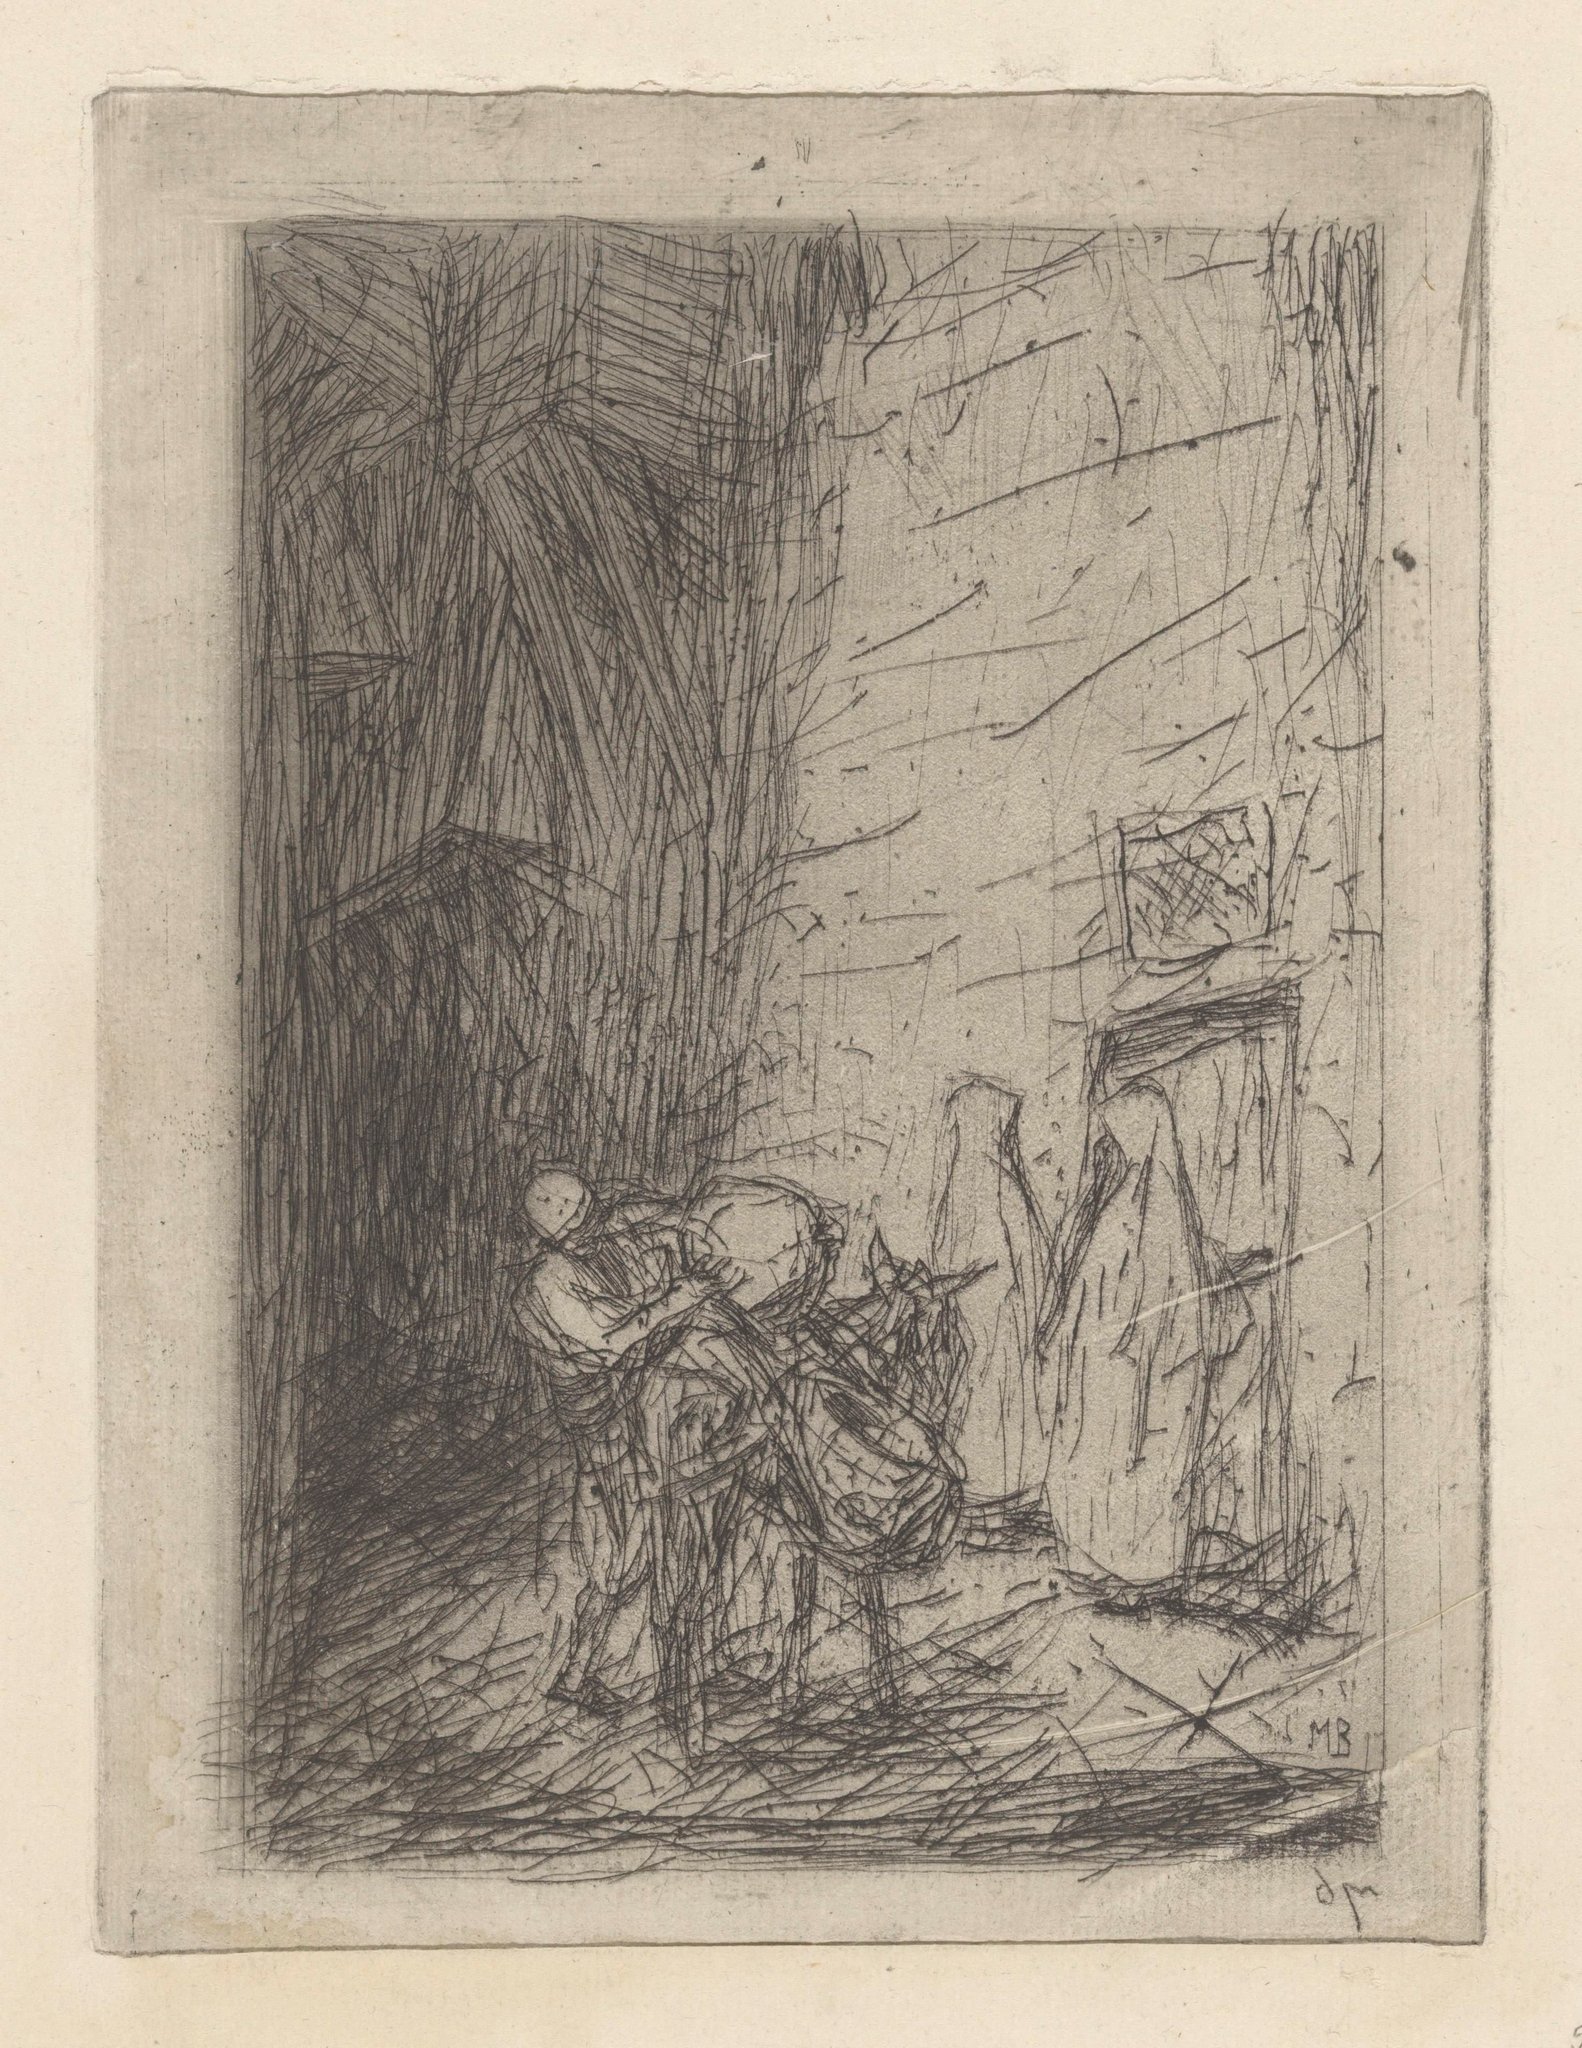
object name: print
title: Ottomaanse koopman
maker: marius bauer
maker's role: draughtsman, print maker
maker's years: 1867-1932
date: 1889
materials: paper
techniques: etching, intaglio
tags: ass, donkey, merchant, salesman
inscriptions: collector's mark: Lugt 2228